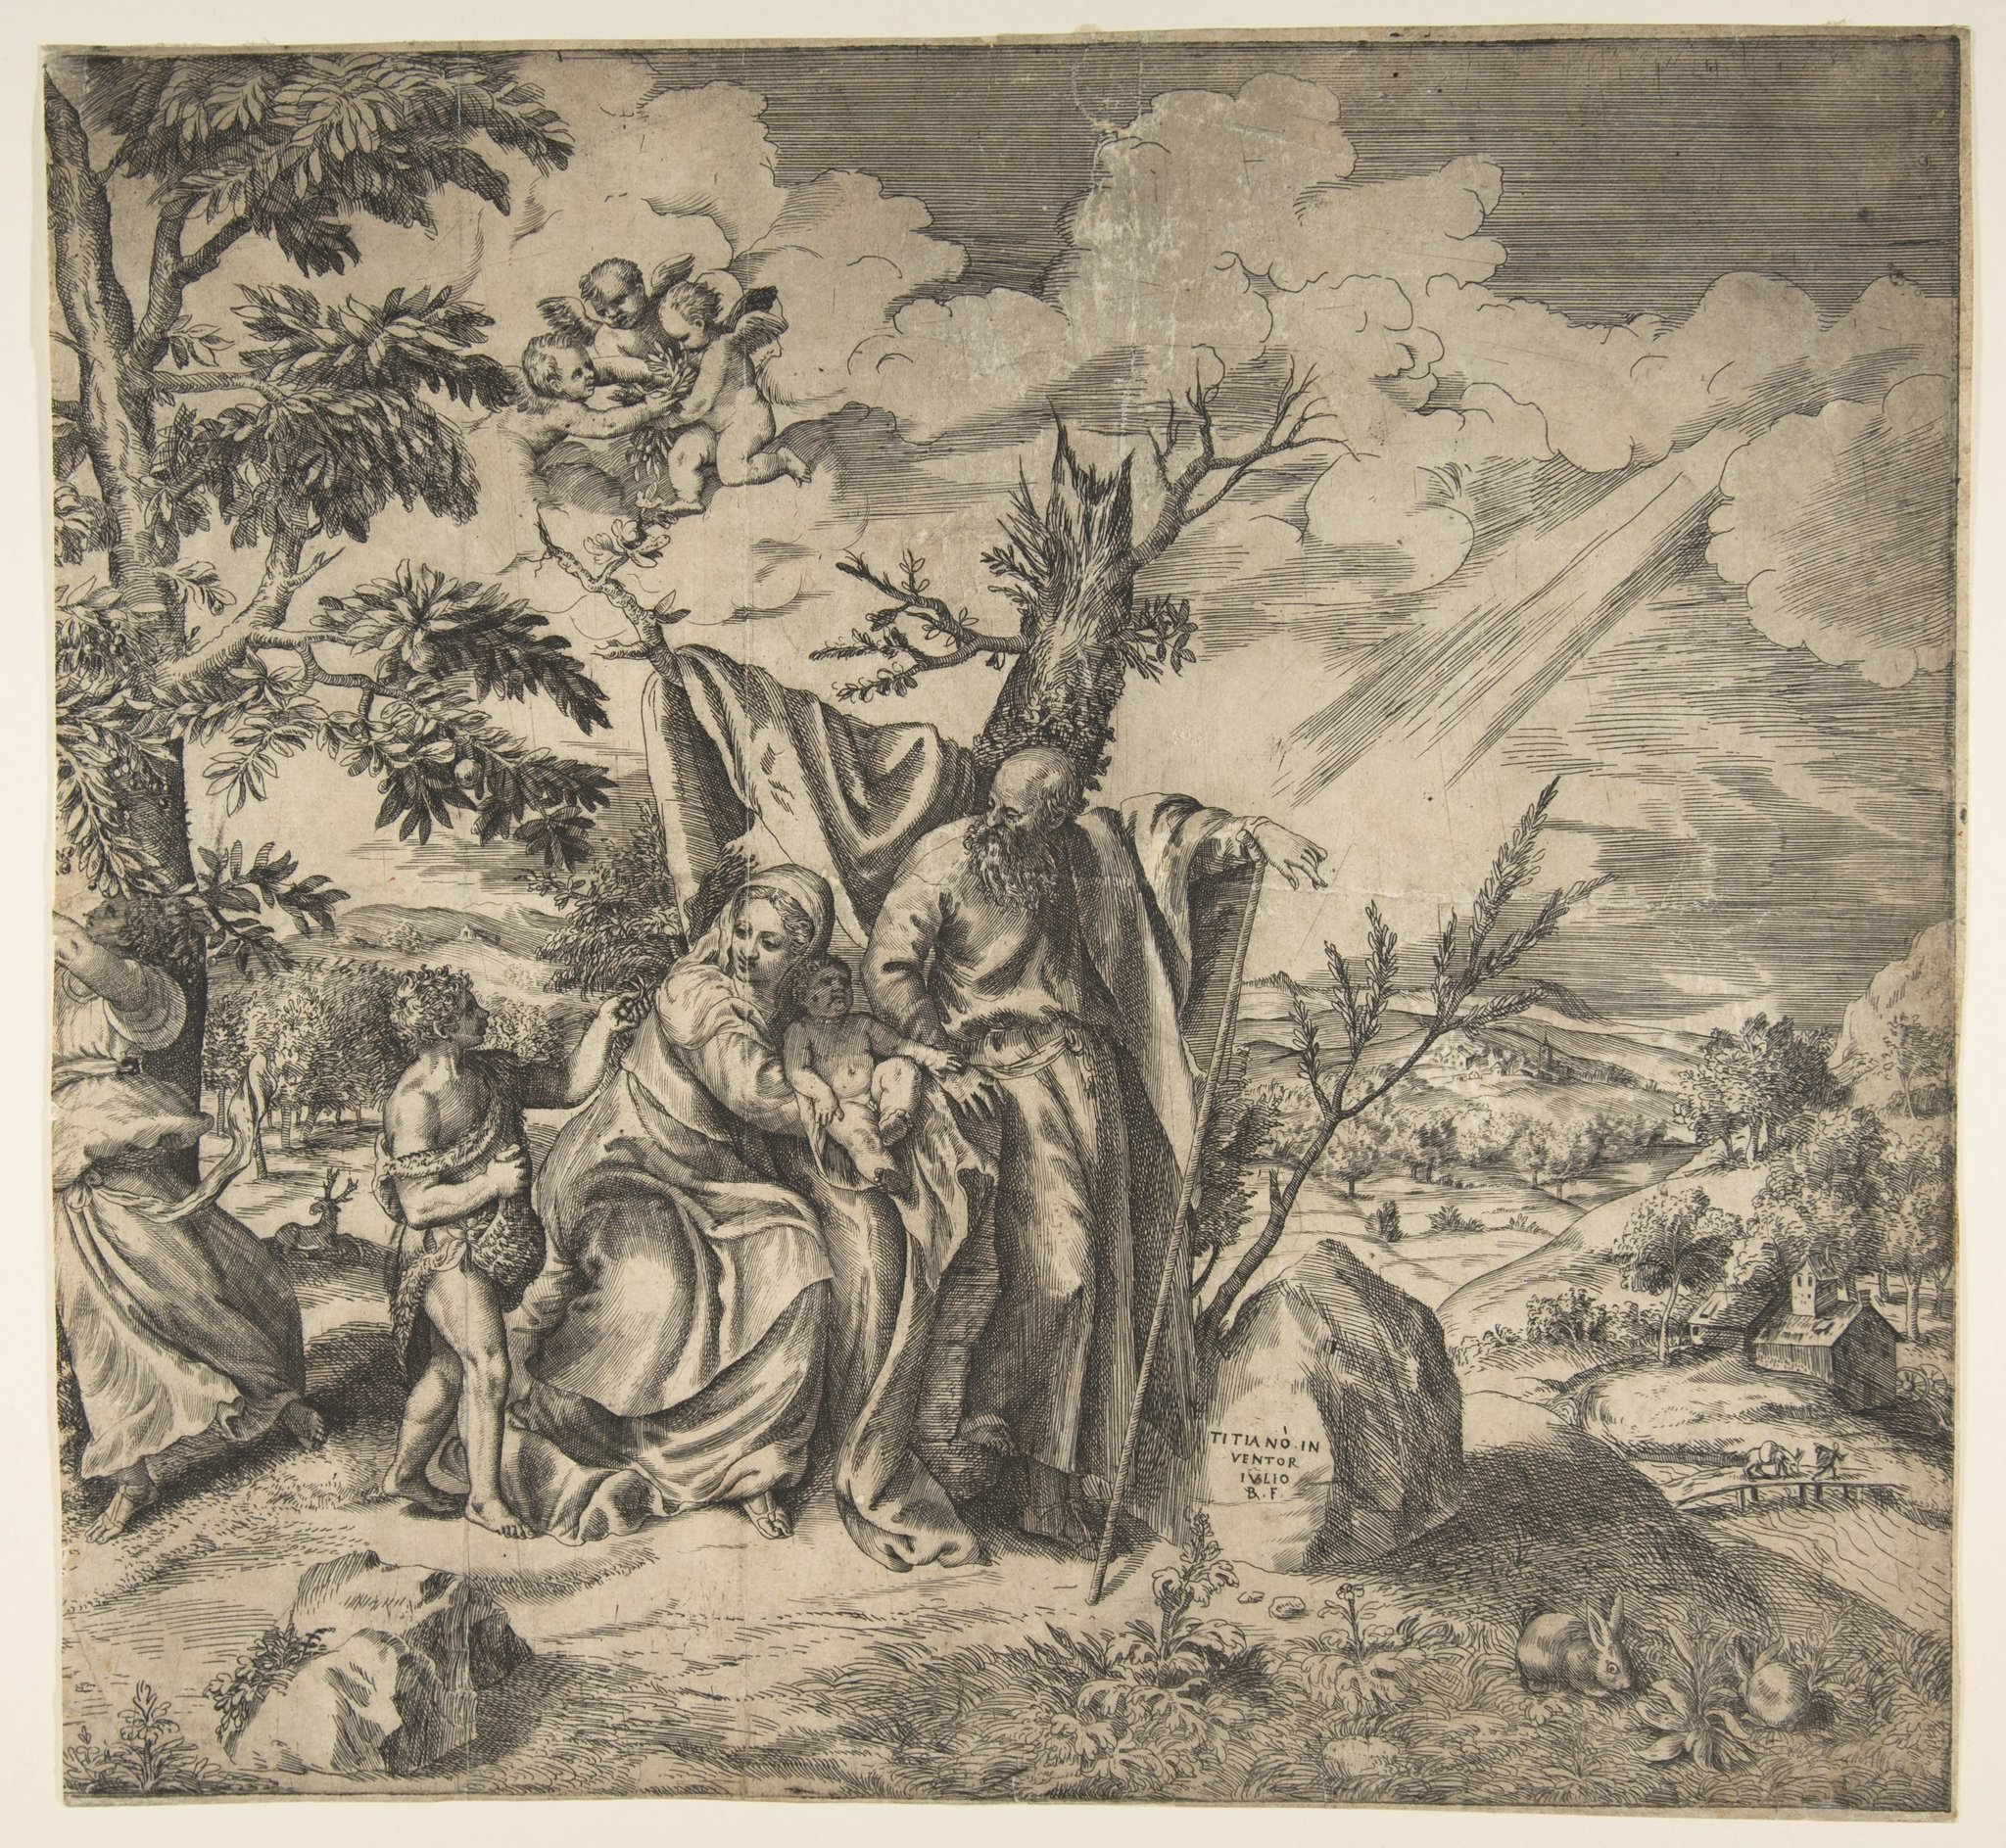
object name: print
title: The rest of the Holy Family on their flight to Egypt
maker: giulio bonasone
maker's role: artist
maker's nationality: italian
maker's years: 1510-1576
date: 1531-1576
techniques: engraving, etching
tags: angels,holy family